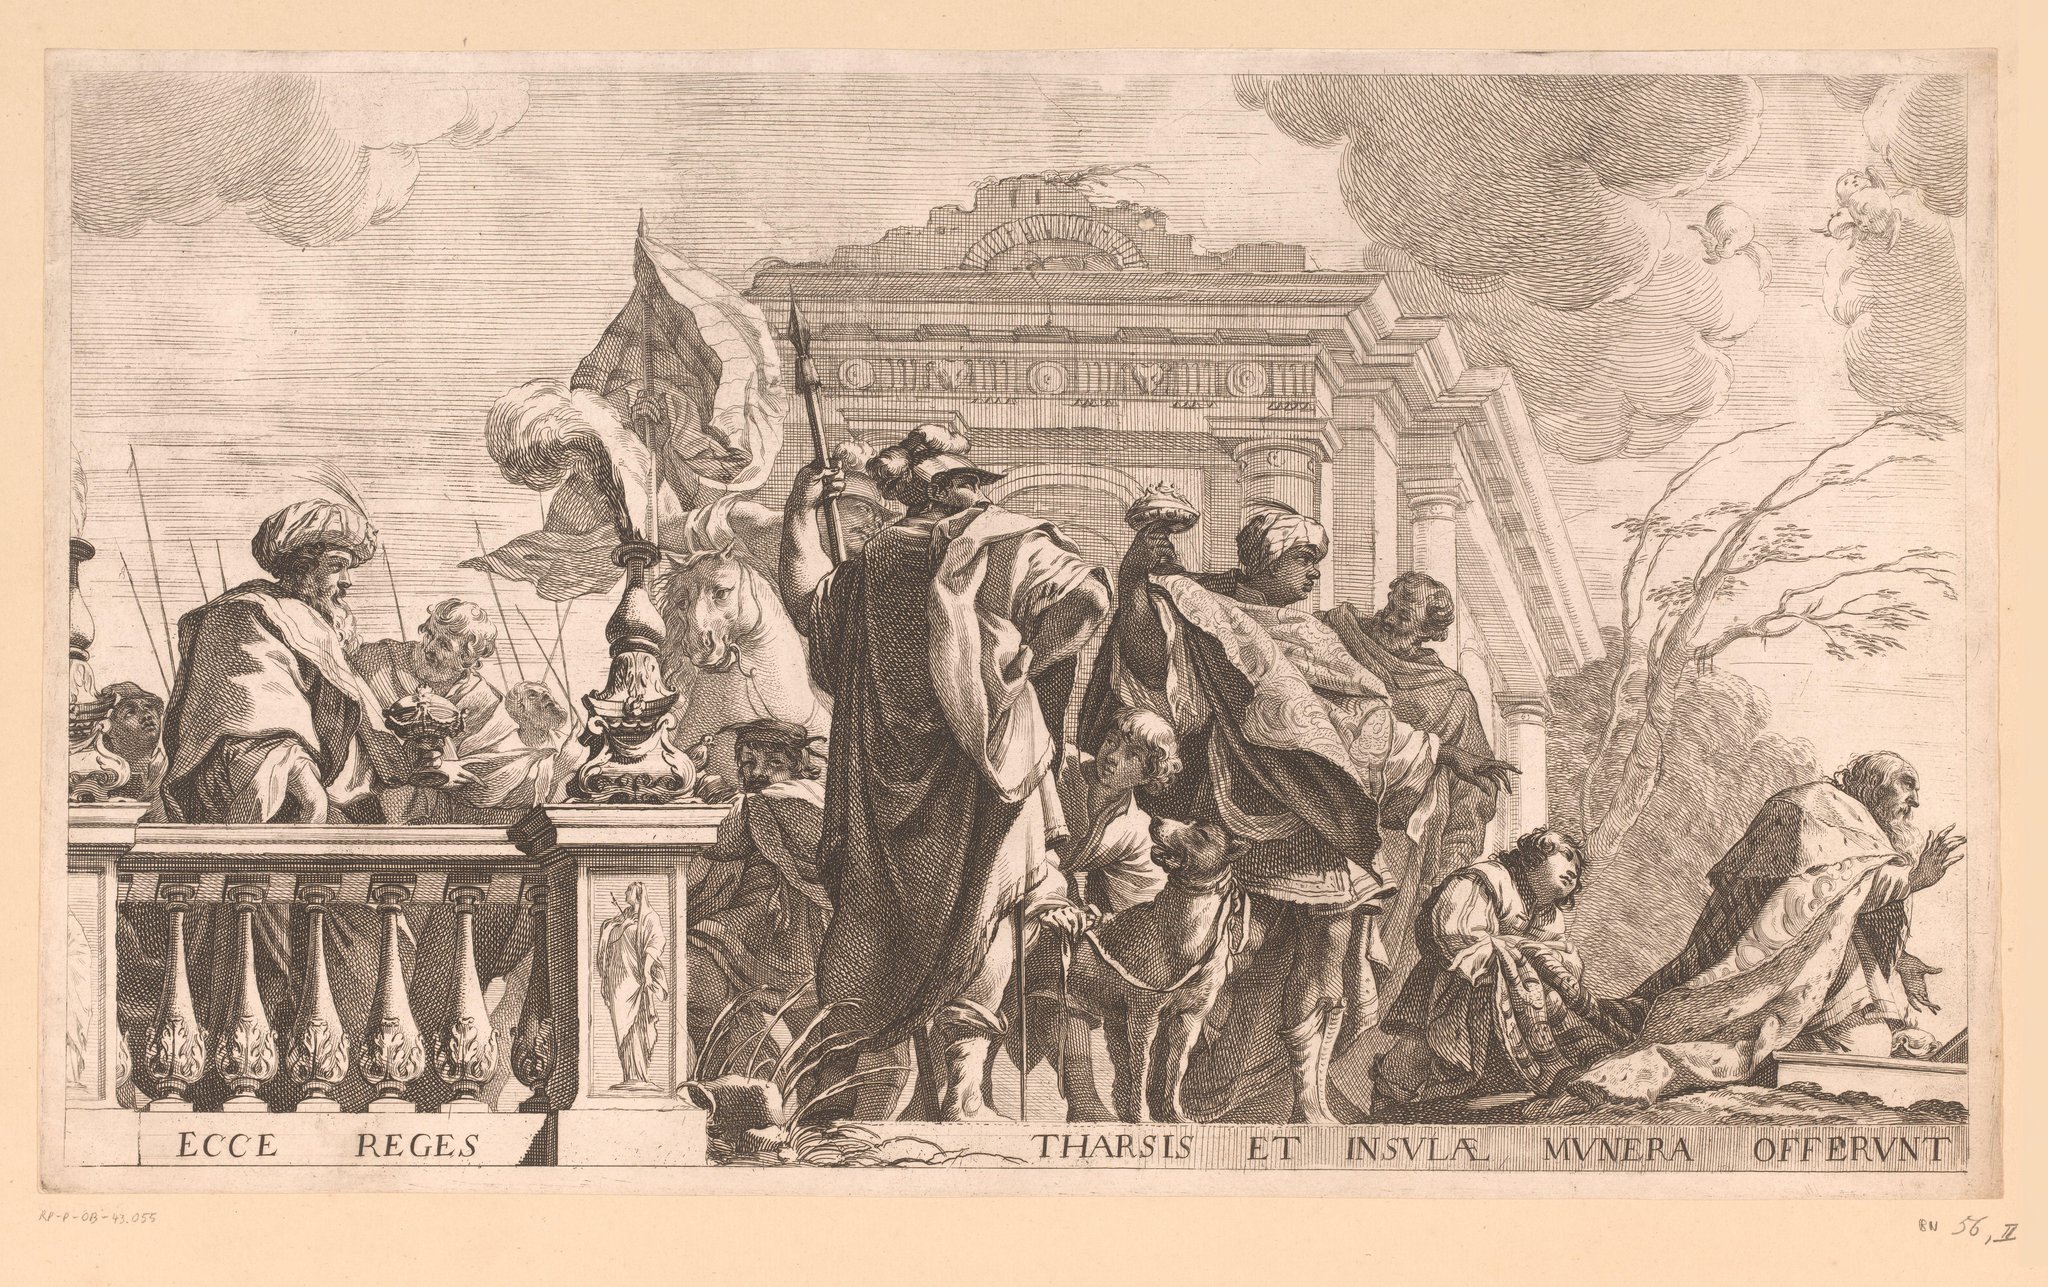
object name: print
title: Aanbidding door de koningen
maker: michel dorigny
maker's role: draughtsman, painter, print maker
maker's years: 1616-1665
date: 1638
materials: paper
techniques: engraving, etching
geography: france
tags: adoration of the kings: the wise men present their gifts to the christ-child (gold, frankincense and myrrh)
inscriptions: collector's mark: Lugt 240